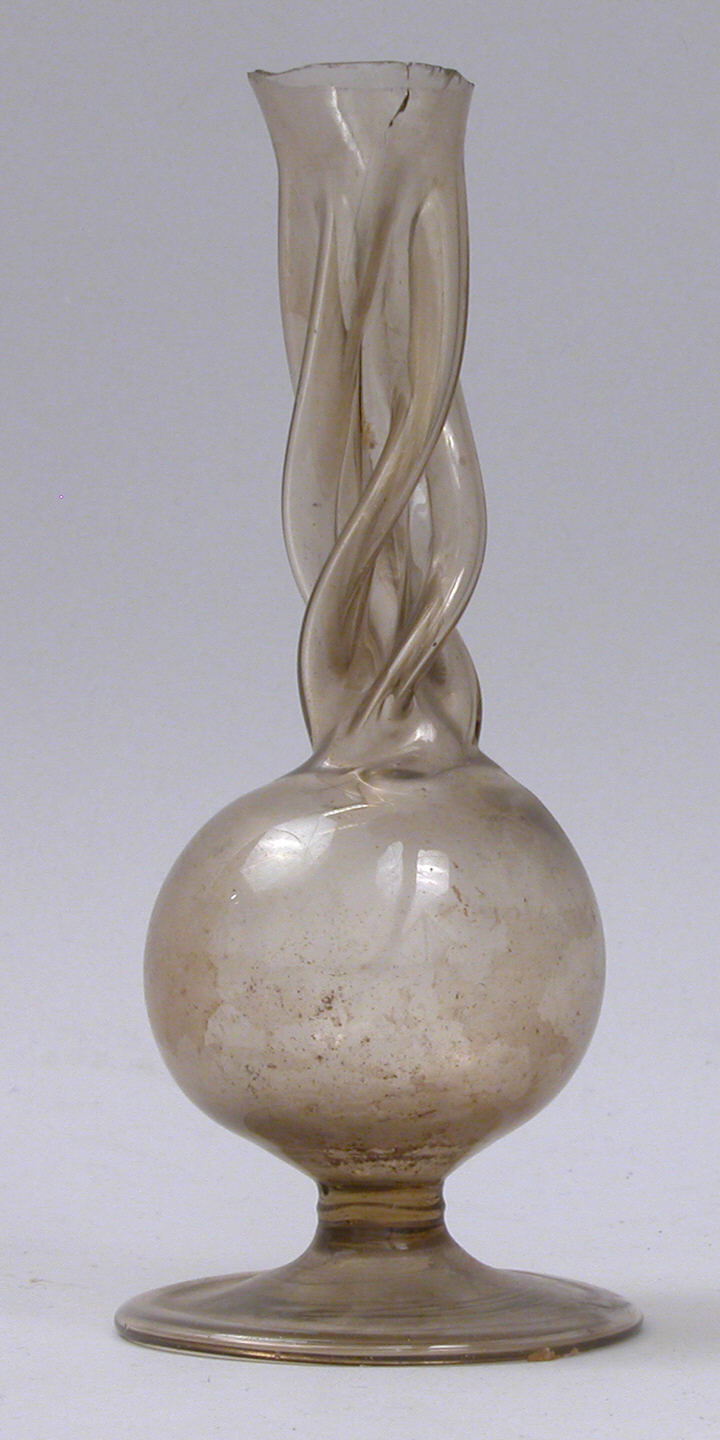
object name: vase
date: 1701-1900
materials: glass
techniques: glassblowing, tooling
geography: iran